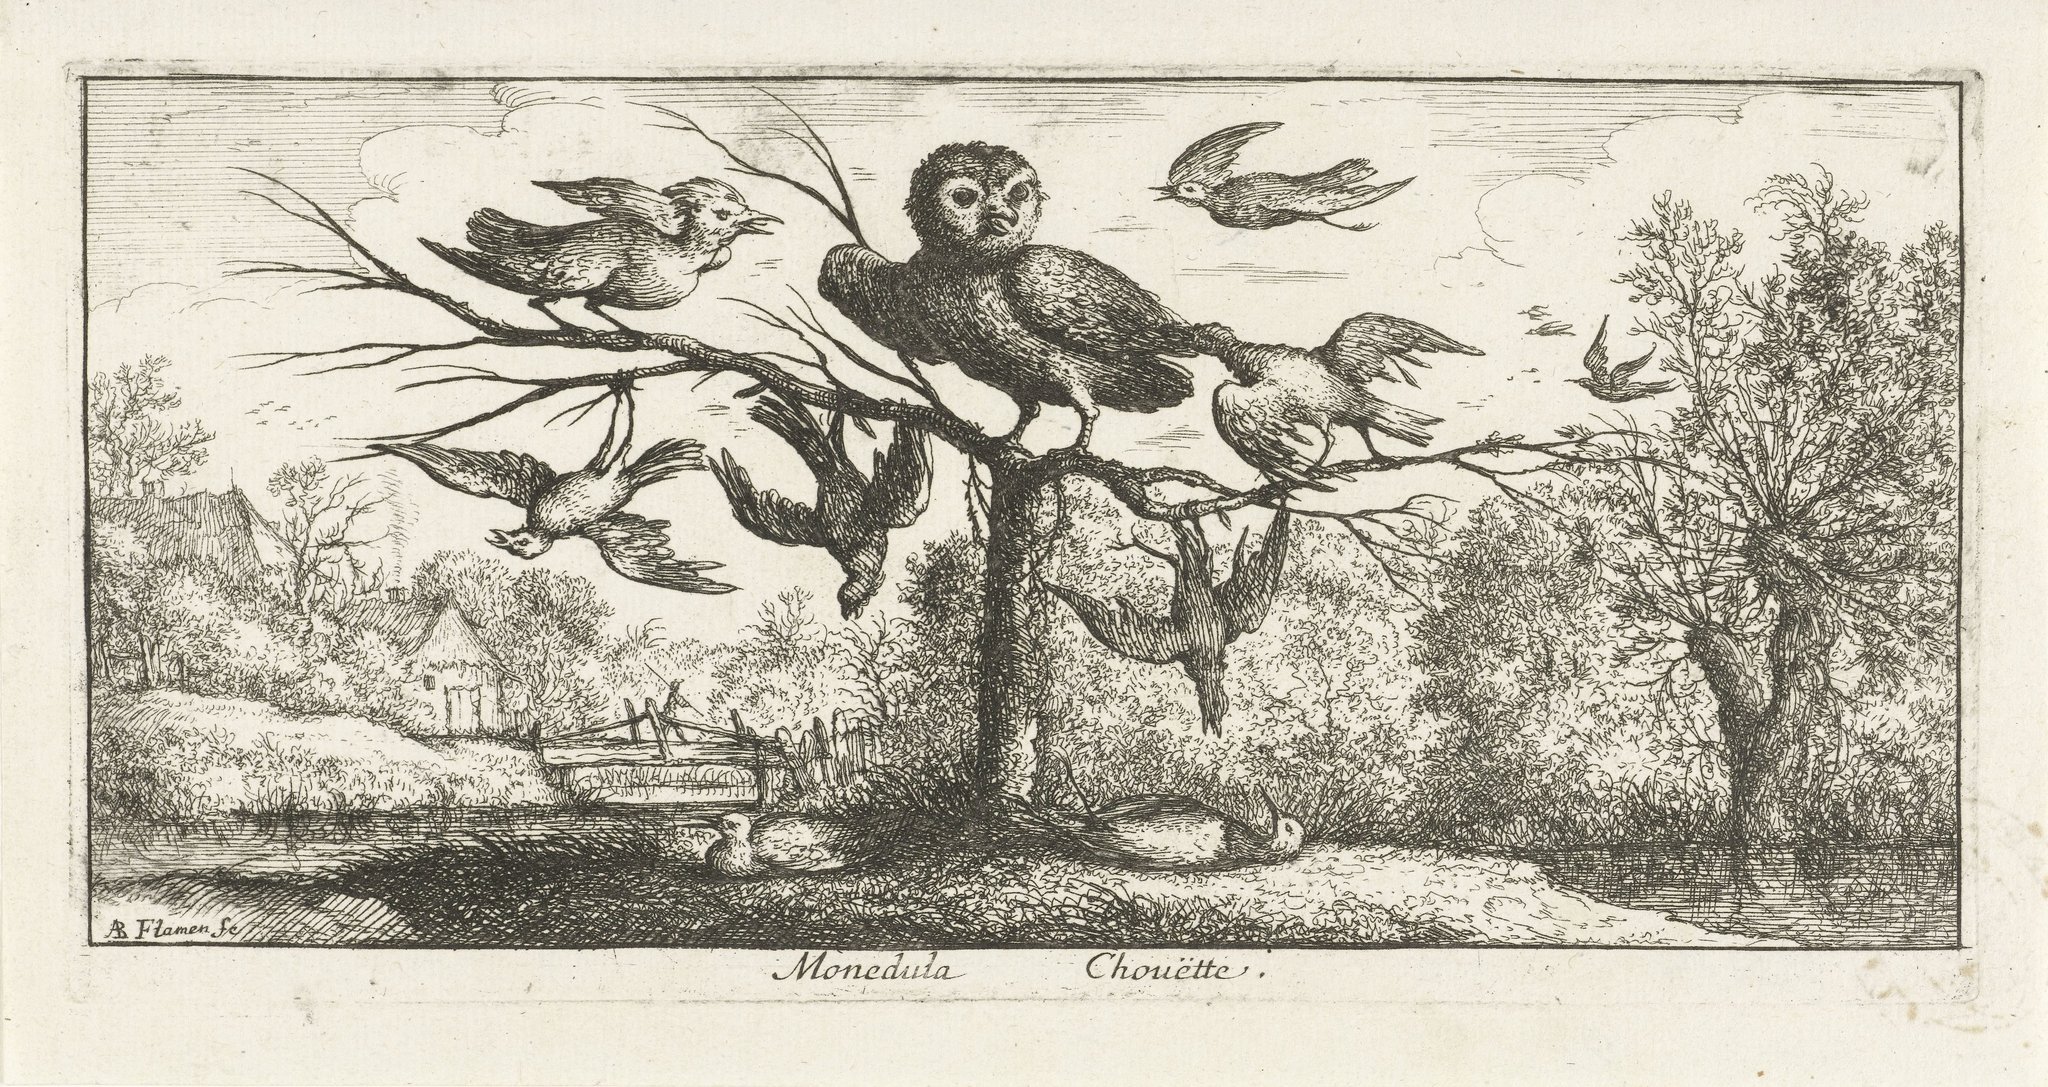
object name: print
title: Livre d'oyseavx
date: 1648-1692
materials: paper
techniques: etching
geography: france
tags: owls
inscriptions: collector's mark: Lugt 240